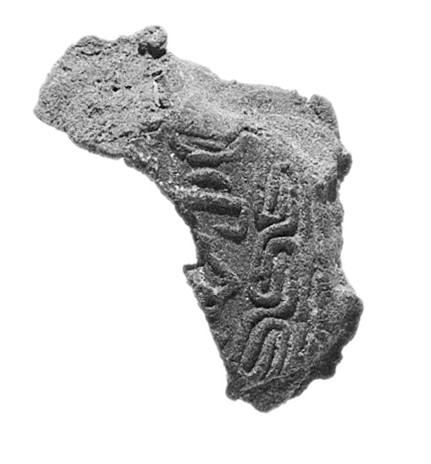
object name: sealing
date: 1981-1640 BCE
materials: mud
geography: egypt